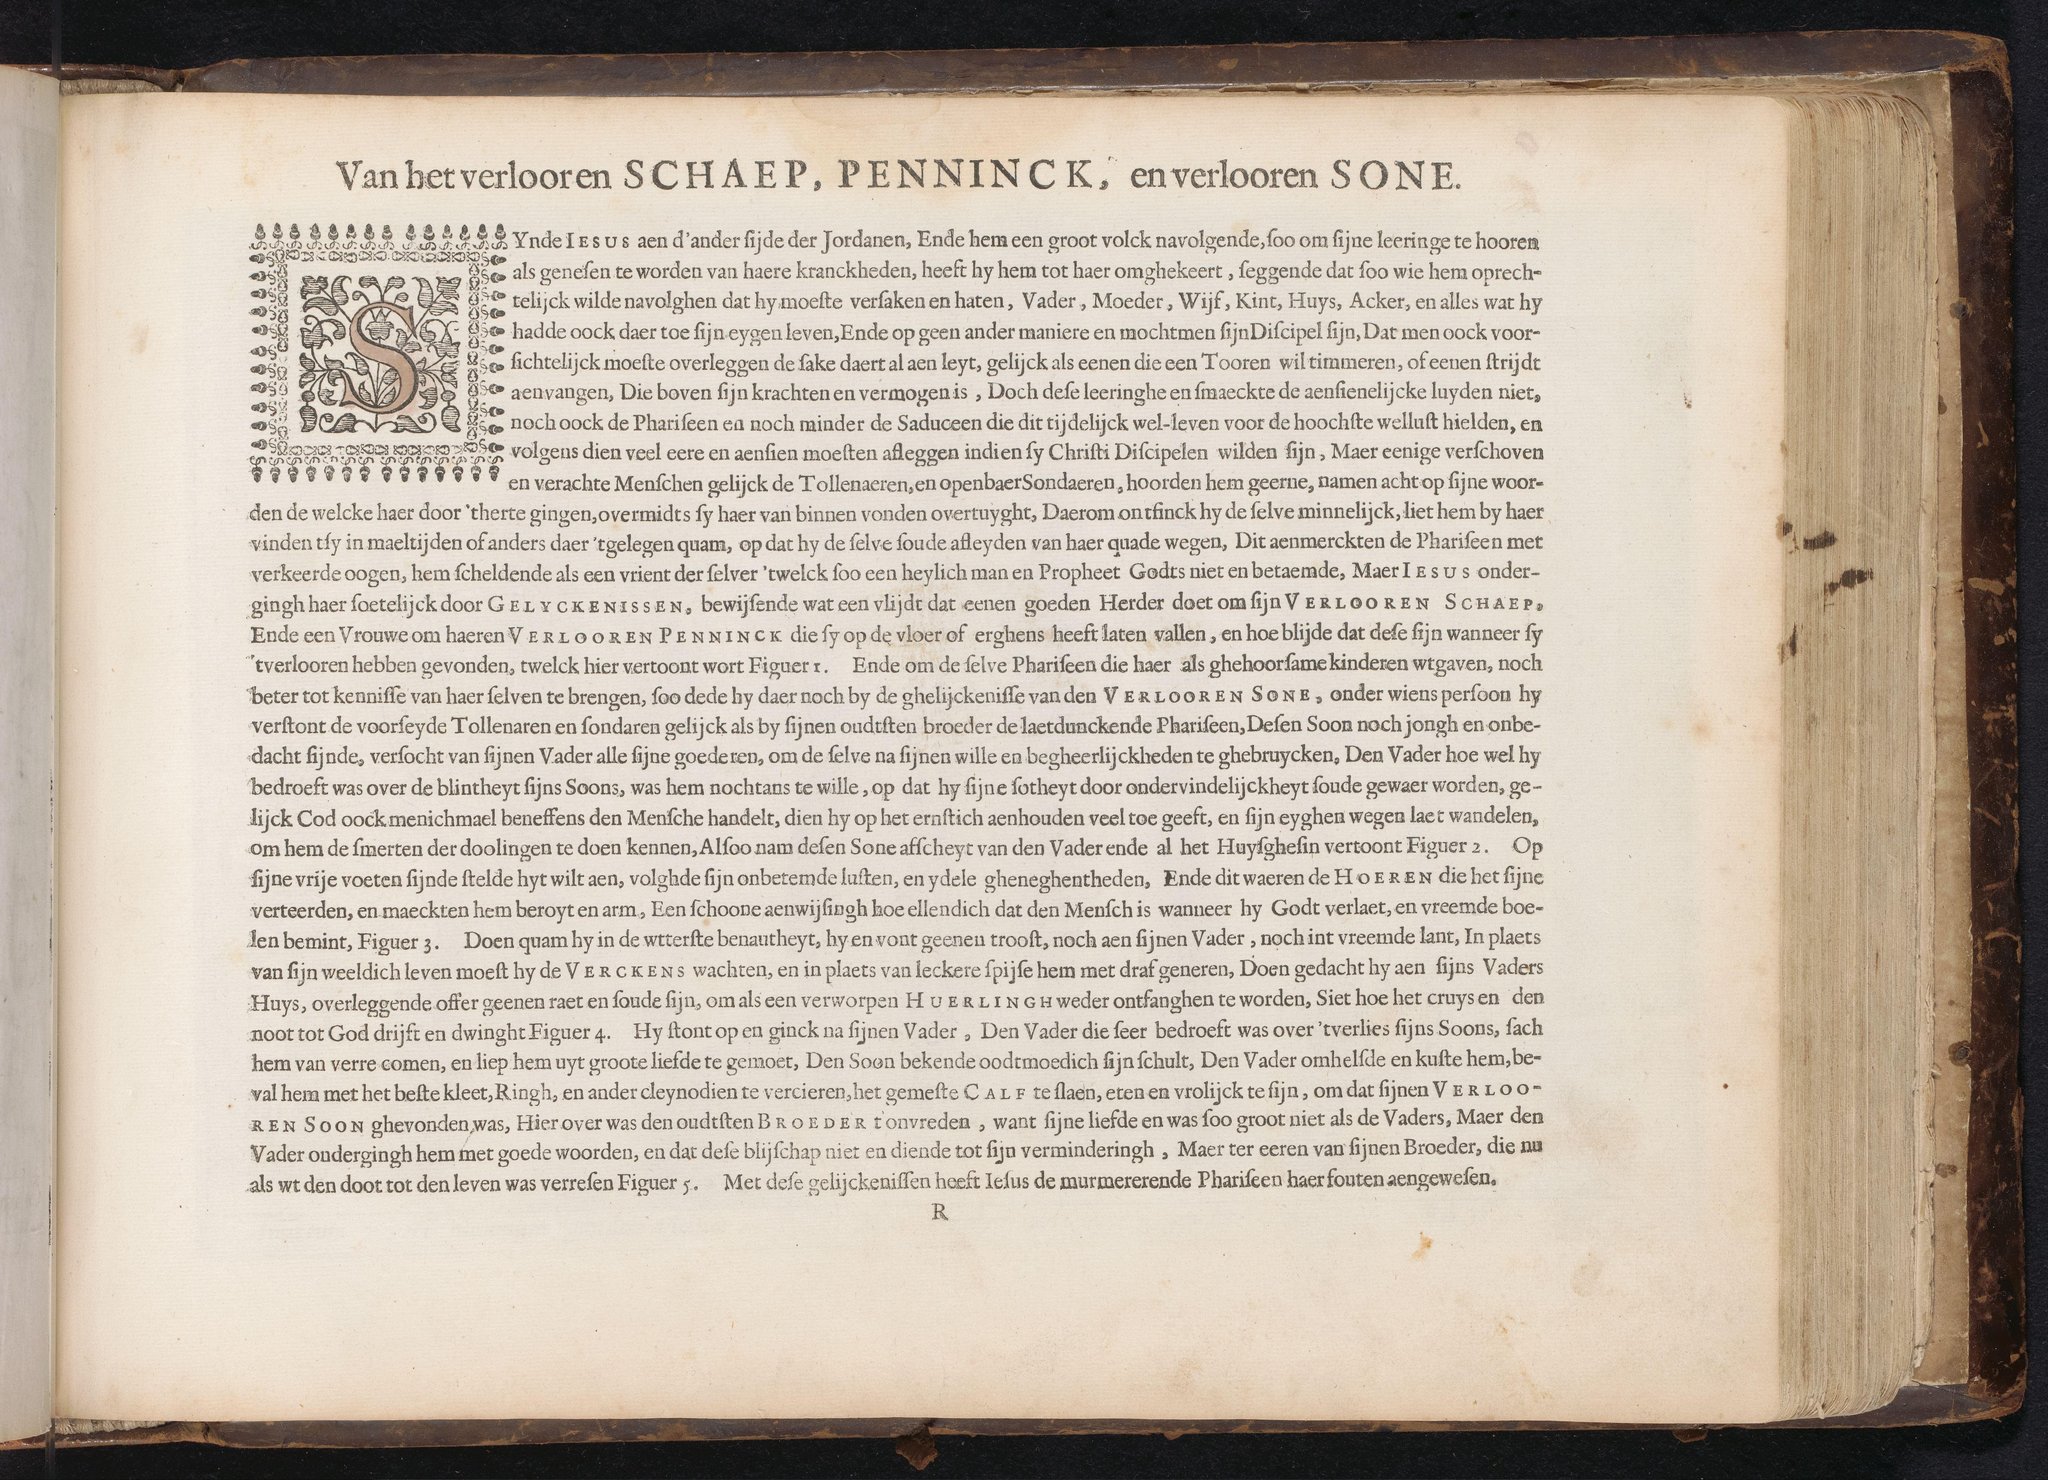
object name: album leaf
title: Van het verlooren Schaep, Penninck, en verlooren Sone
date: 1646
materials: paper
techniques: hand coloring, letterpress printing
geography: alkmaar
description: Tekstblad bij een serie prenten over de gelijkenissen van het verloren schaap en het verloren muntstuk en van de verloren zoon. Linksboven initiaal S. Dit blad maakt deel uit van een album.